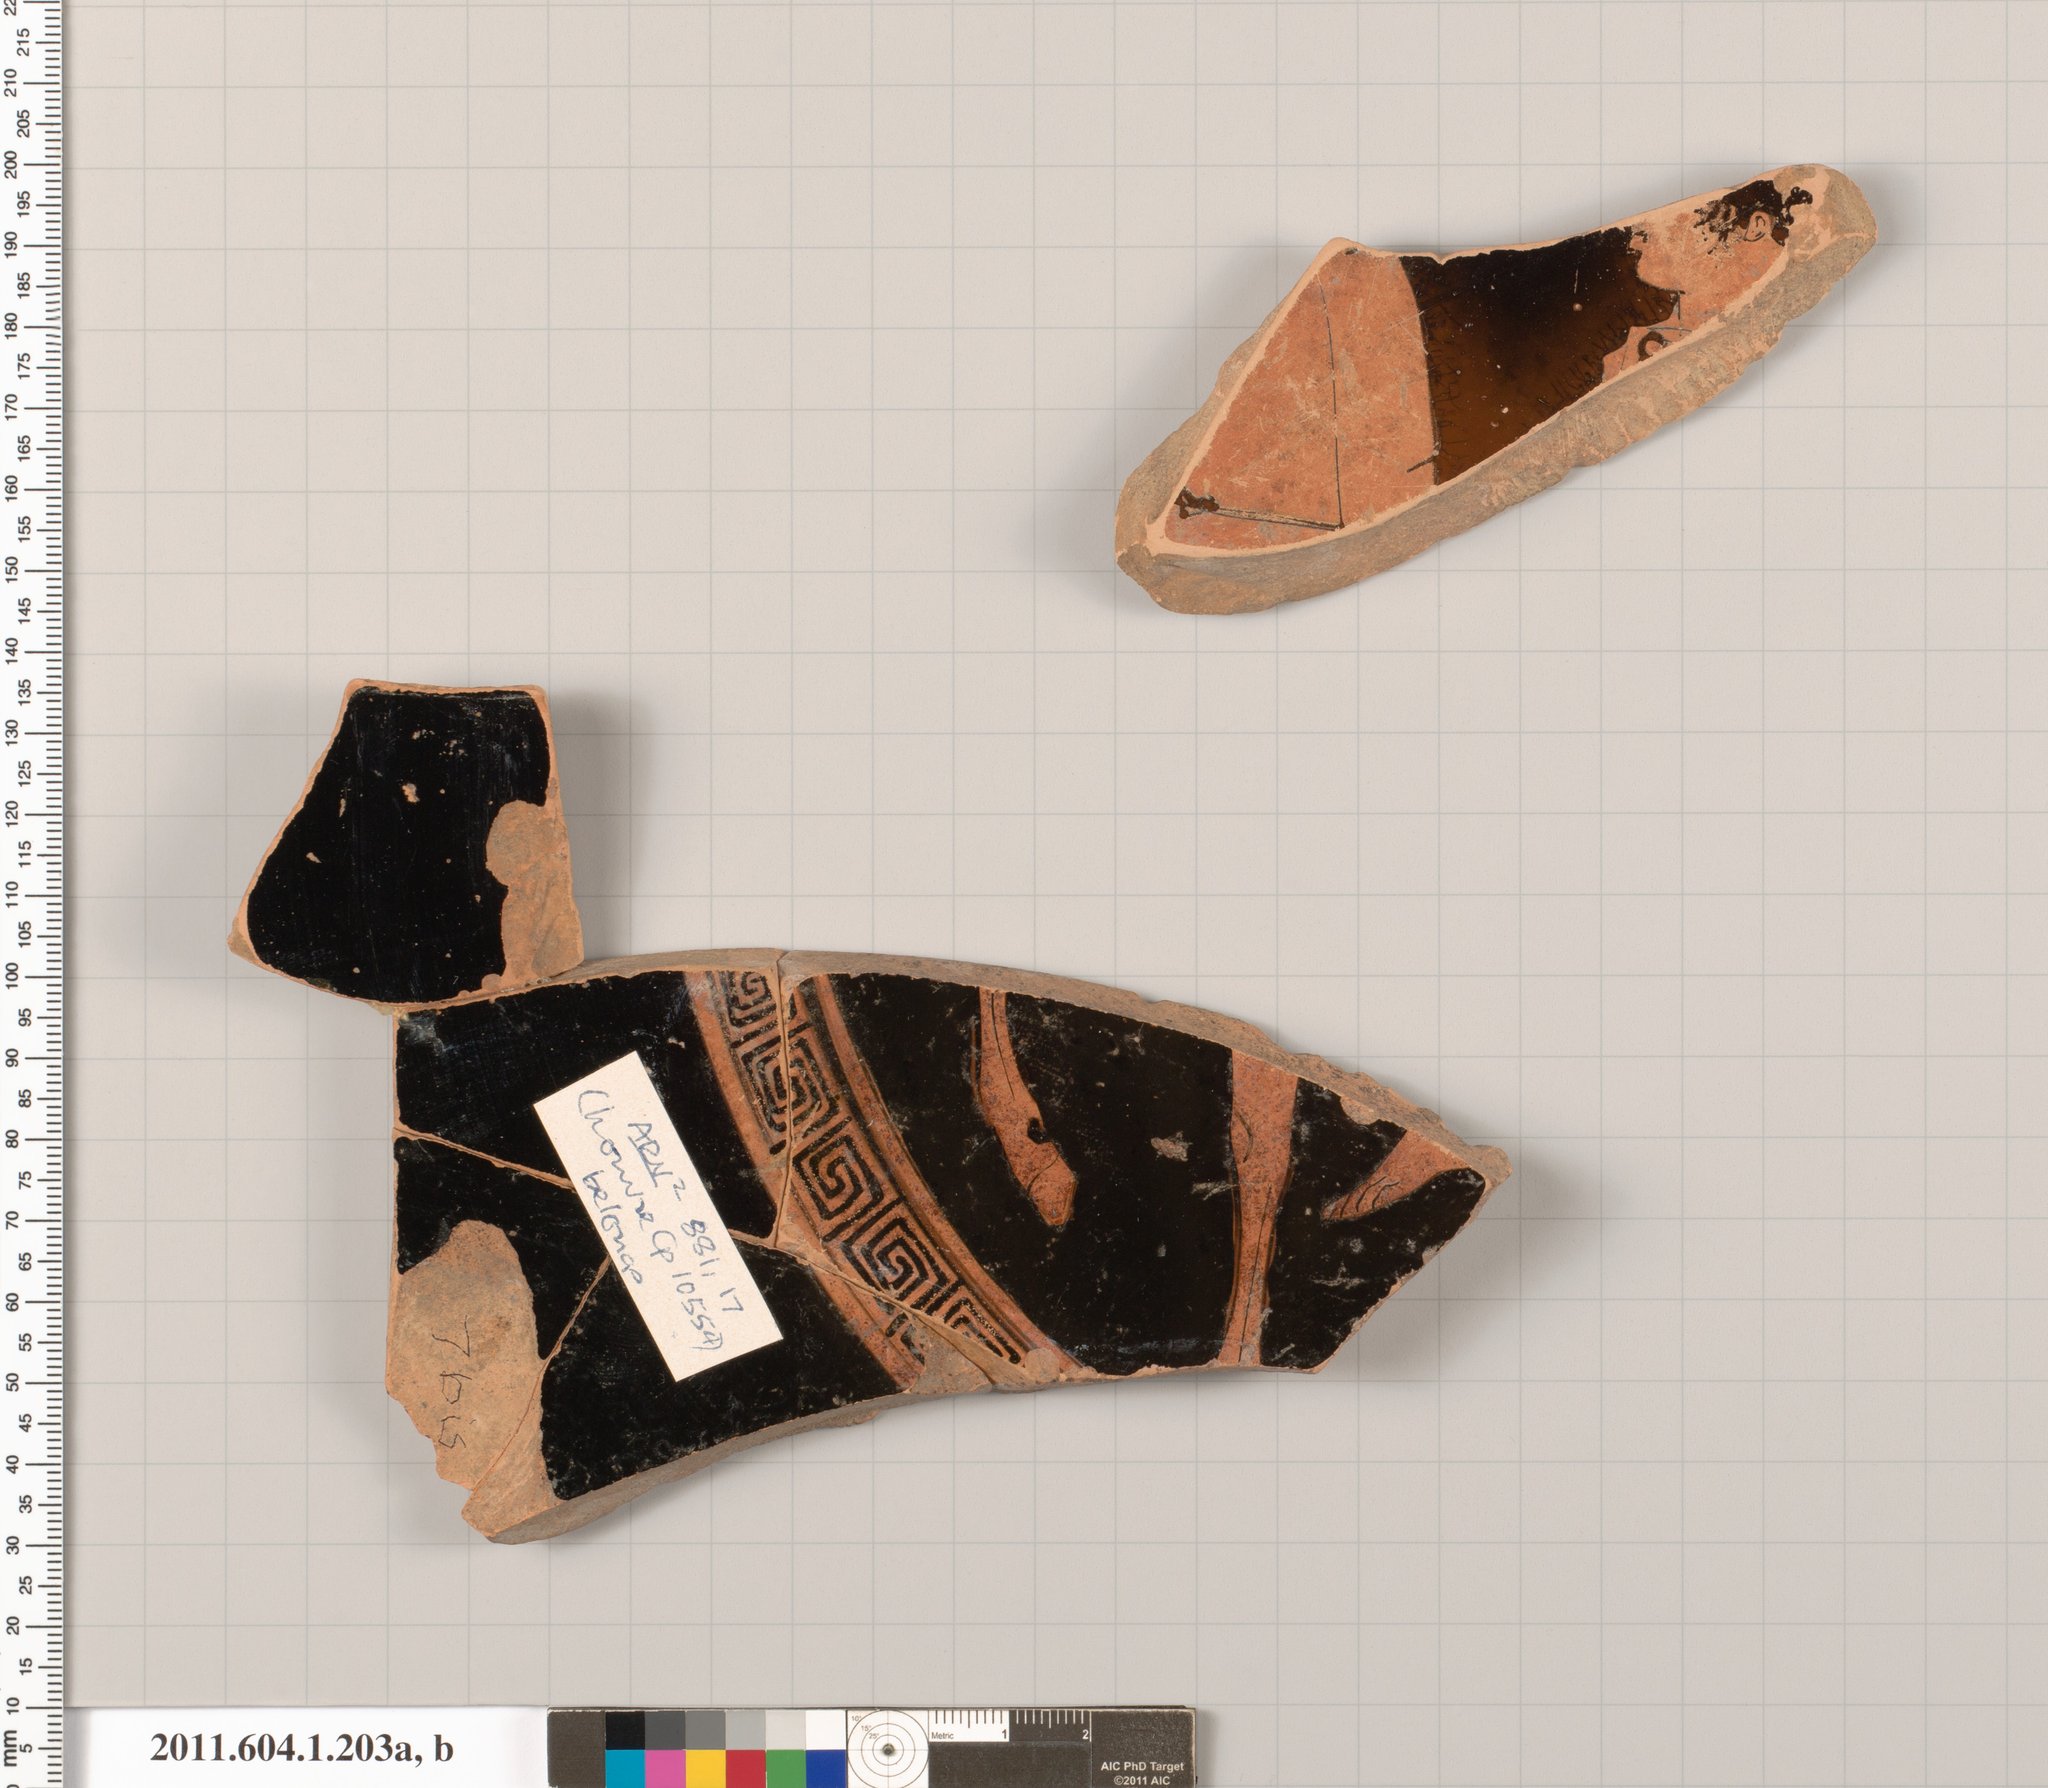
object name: kylix fragment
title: Terracotta fragments of a kylix (drinking cup)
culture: greek, attic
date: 475-451 BCE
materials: terracotta